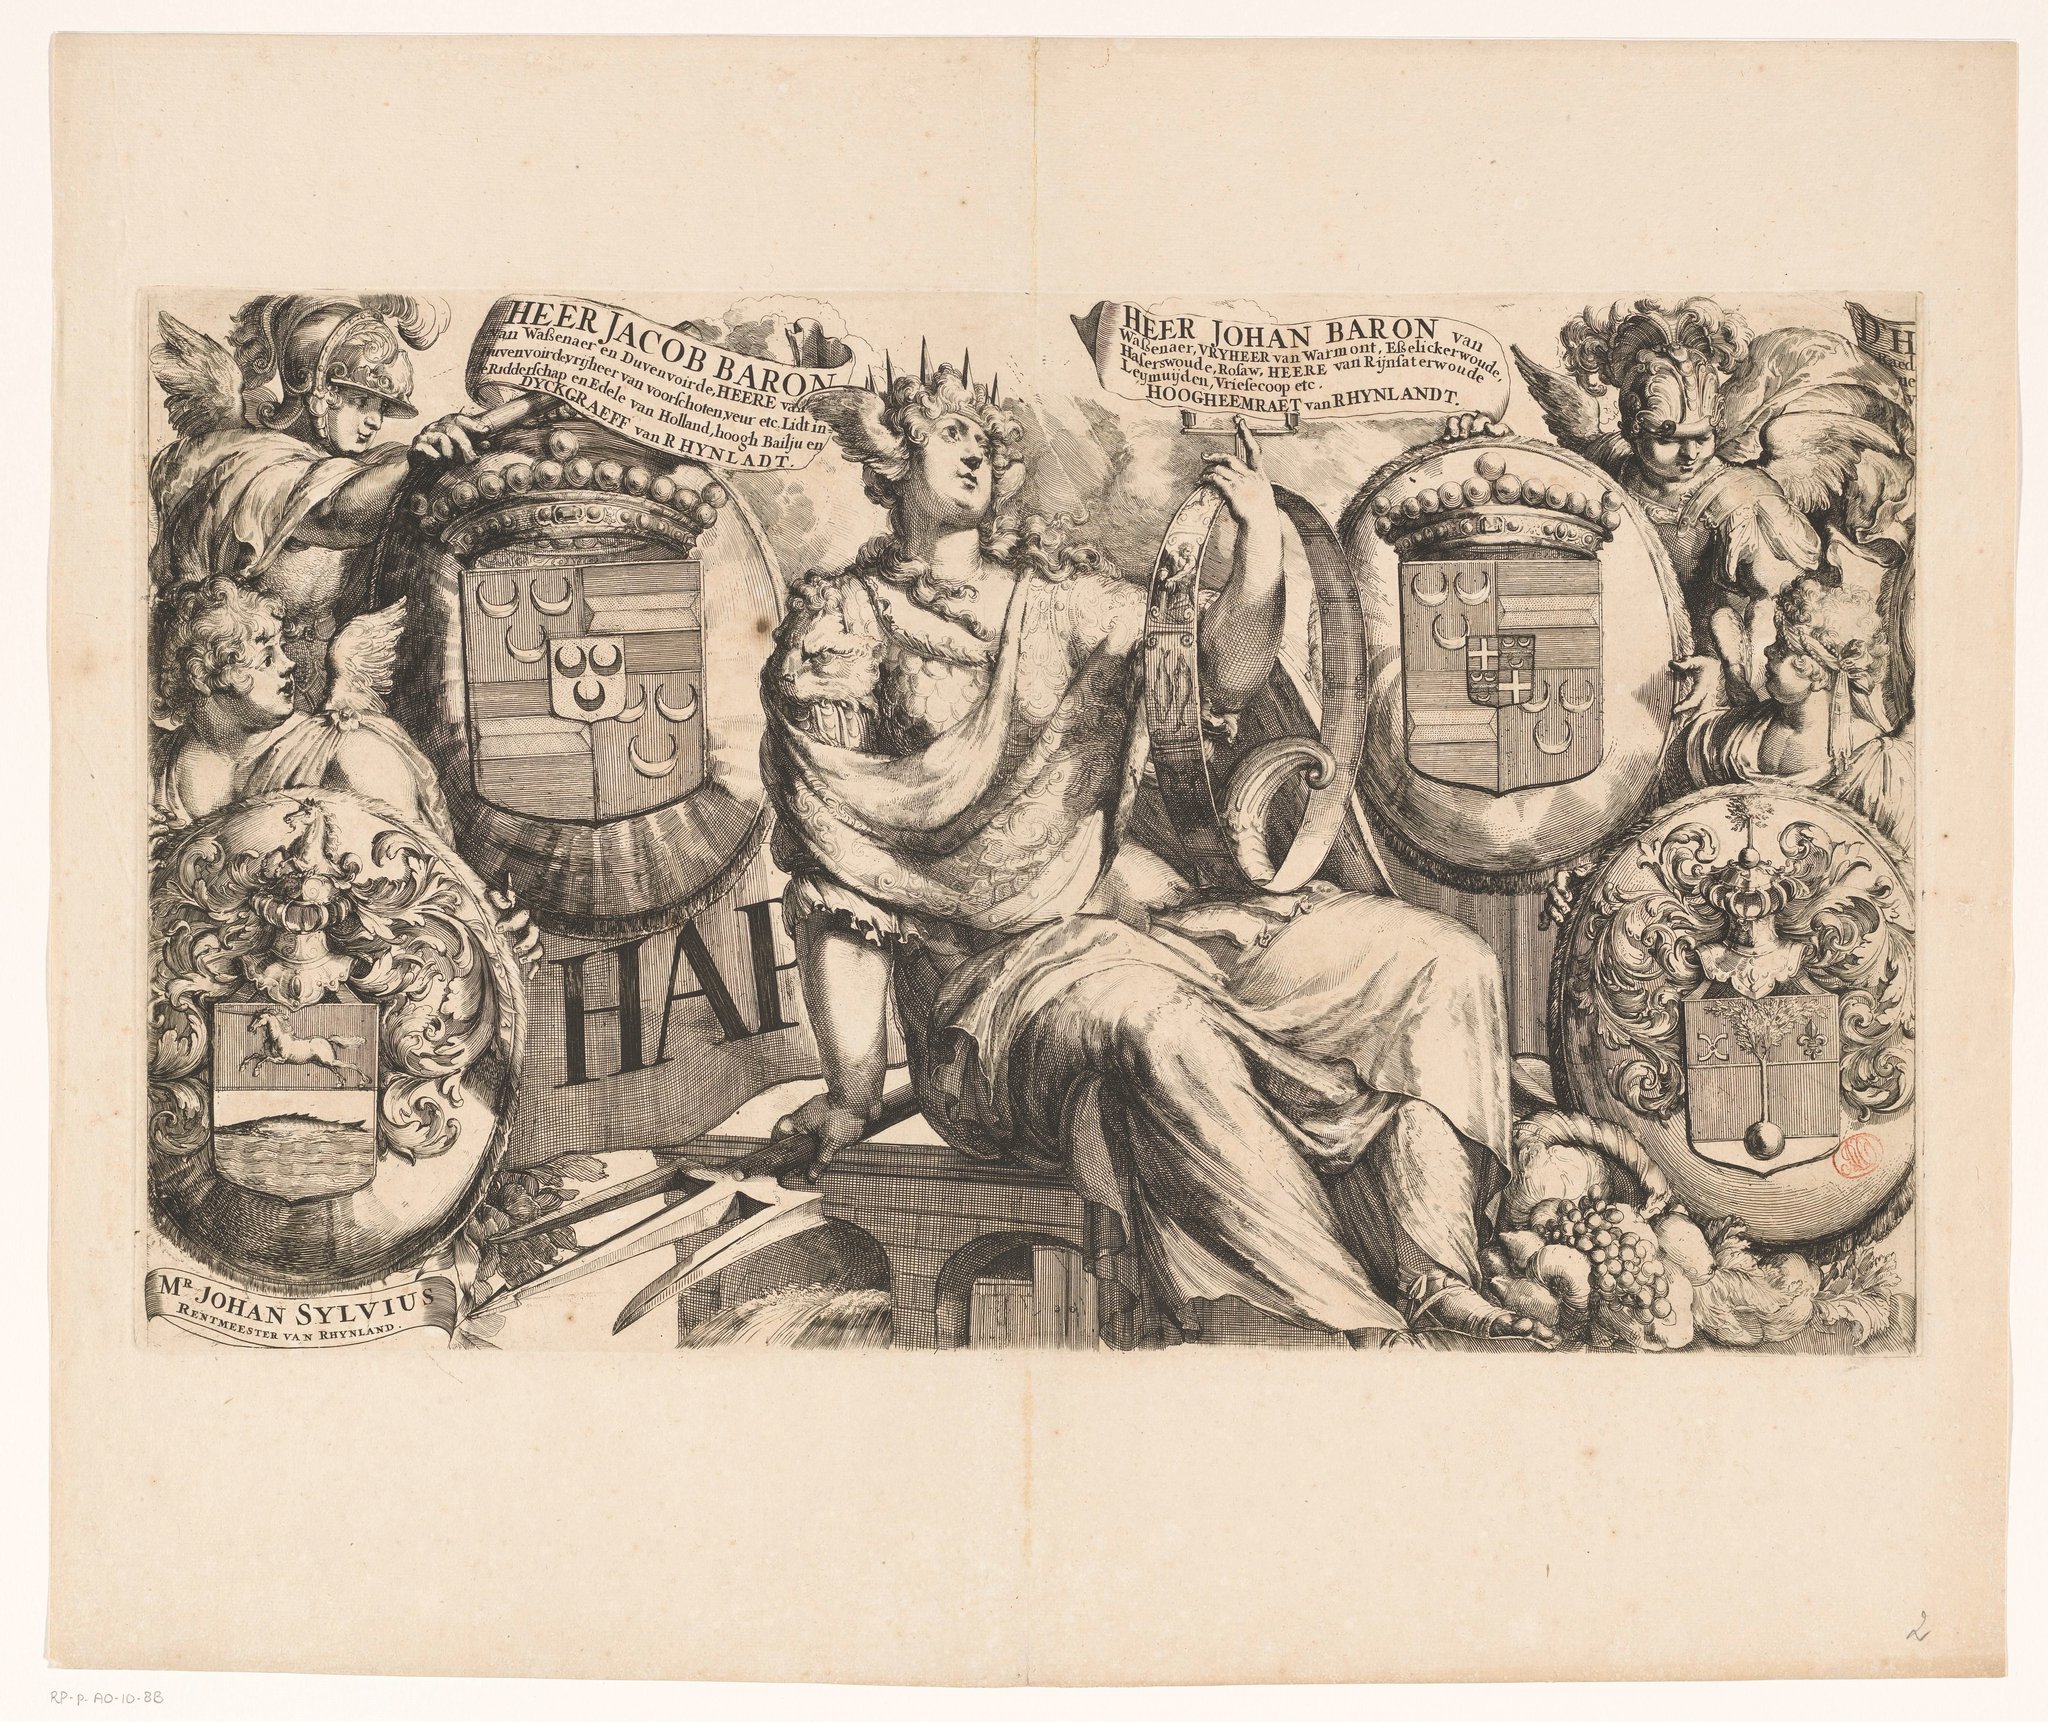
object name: print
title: Kaart van het Hoogheemraadschap van Rijnland (tweede deel)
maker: romeyn de hooghe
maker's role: draughtsman, goldsmith, painter, print maker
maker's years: 1645-1708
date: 1687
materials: paper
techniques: engraving, etching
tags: armorial bearing, heraldry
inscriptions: collector's mark: Lugt 195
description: Deze prent behoort tot de tweede druk (1687) van 'T' Hoogheymraedschap van Rhynland', een wandkaart van het Hoogheemraadschap van Rijnland bestaande uit een kaart van het gebied en een sierrand. Van deze kaart zijn voor zover na te gaan drie verschillende drukken bekend, uit respectievelijk 1647, 1687 en 1746. Het kaartdeel is gedrukt van twaalf platen die voor elke druk zijn aangepast. Het vijfde blad van het kaartdeel (RP-P-AO-10-8H) is in of na 1766 nog een keer bijgewerkt en los uitgegeven. Hierdoor zijn van het vijfde blad vier staten bekend en van de overige bladen drie. Zie documentatie voor meer informatie. Bij de eerste en tweede druk hoort een sierrand met daarop de titel, wapenschilden en octrooiverleningen. Delen van de zijkant van de rand van de eerste druk zijn voor de tweede druk herbruikt, terwijl andere delen van de zijkanten en de hele bovenkant nieuw zijn gemaakt door Romeyn de Hooghe. De derde druk heeft slechts een nieuw gemaakte titelstrook langs de bovenkant.